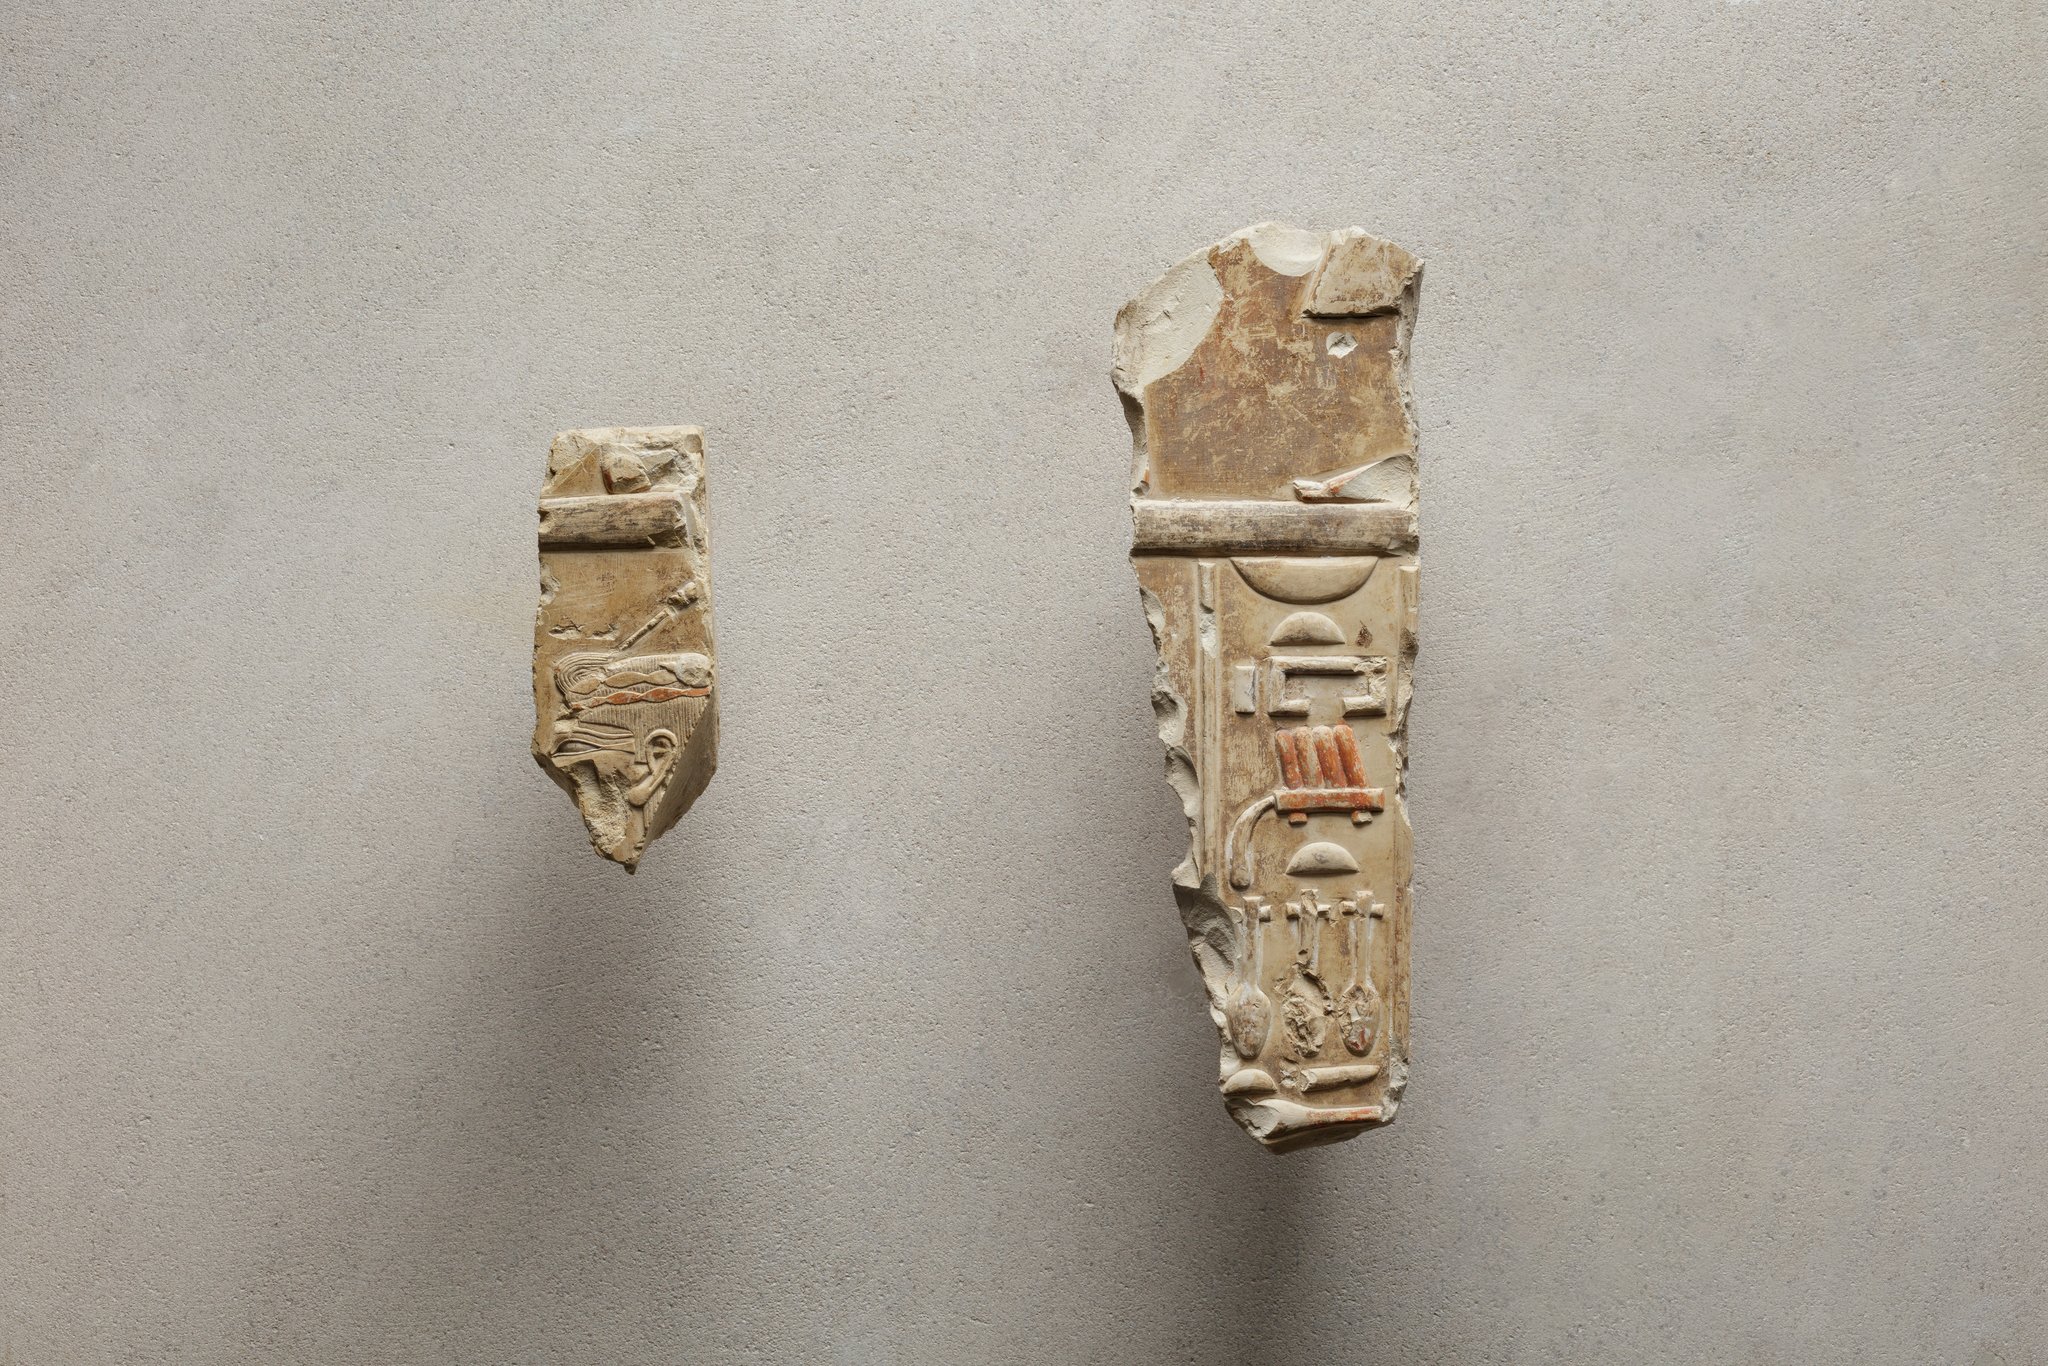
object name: relief, female attendant, neferu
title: Relief of Queen Neferu having her hair done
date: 2051-2030 BCE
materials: limestone, paint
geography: egypt